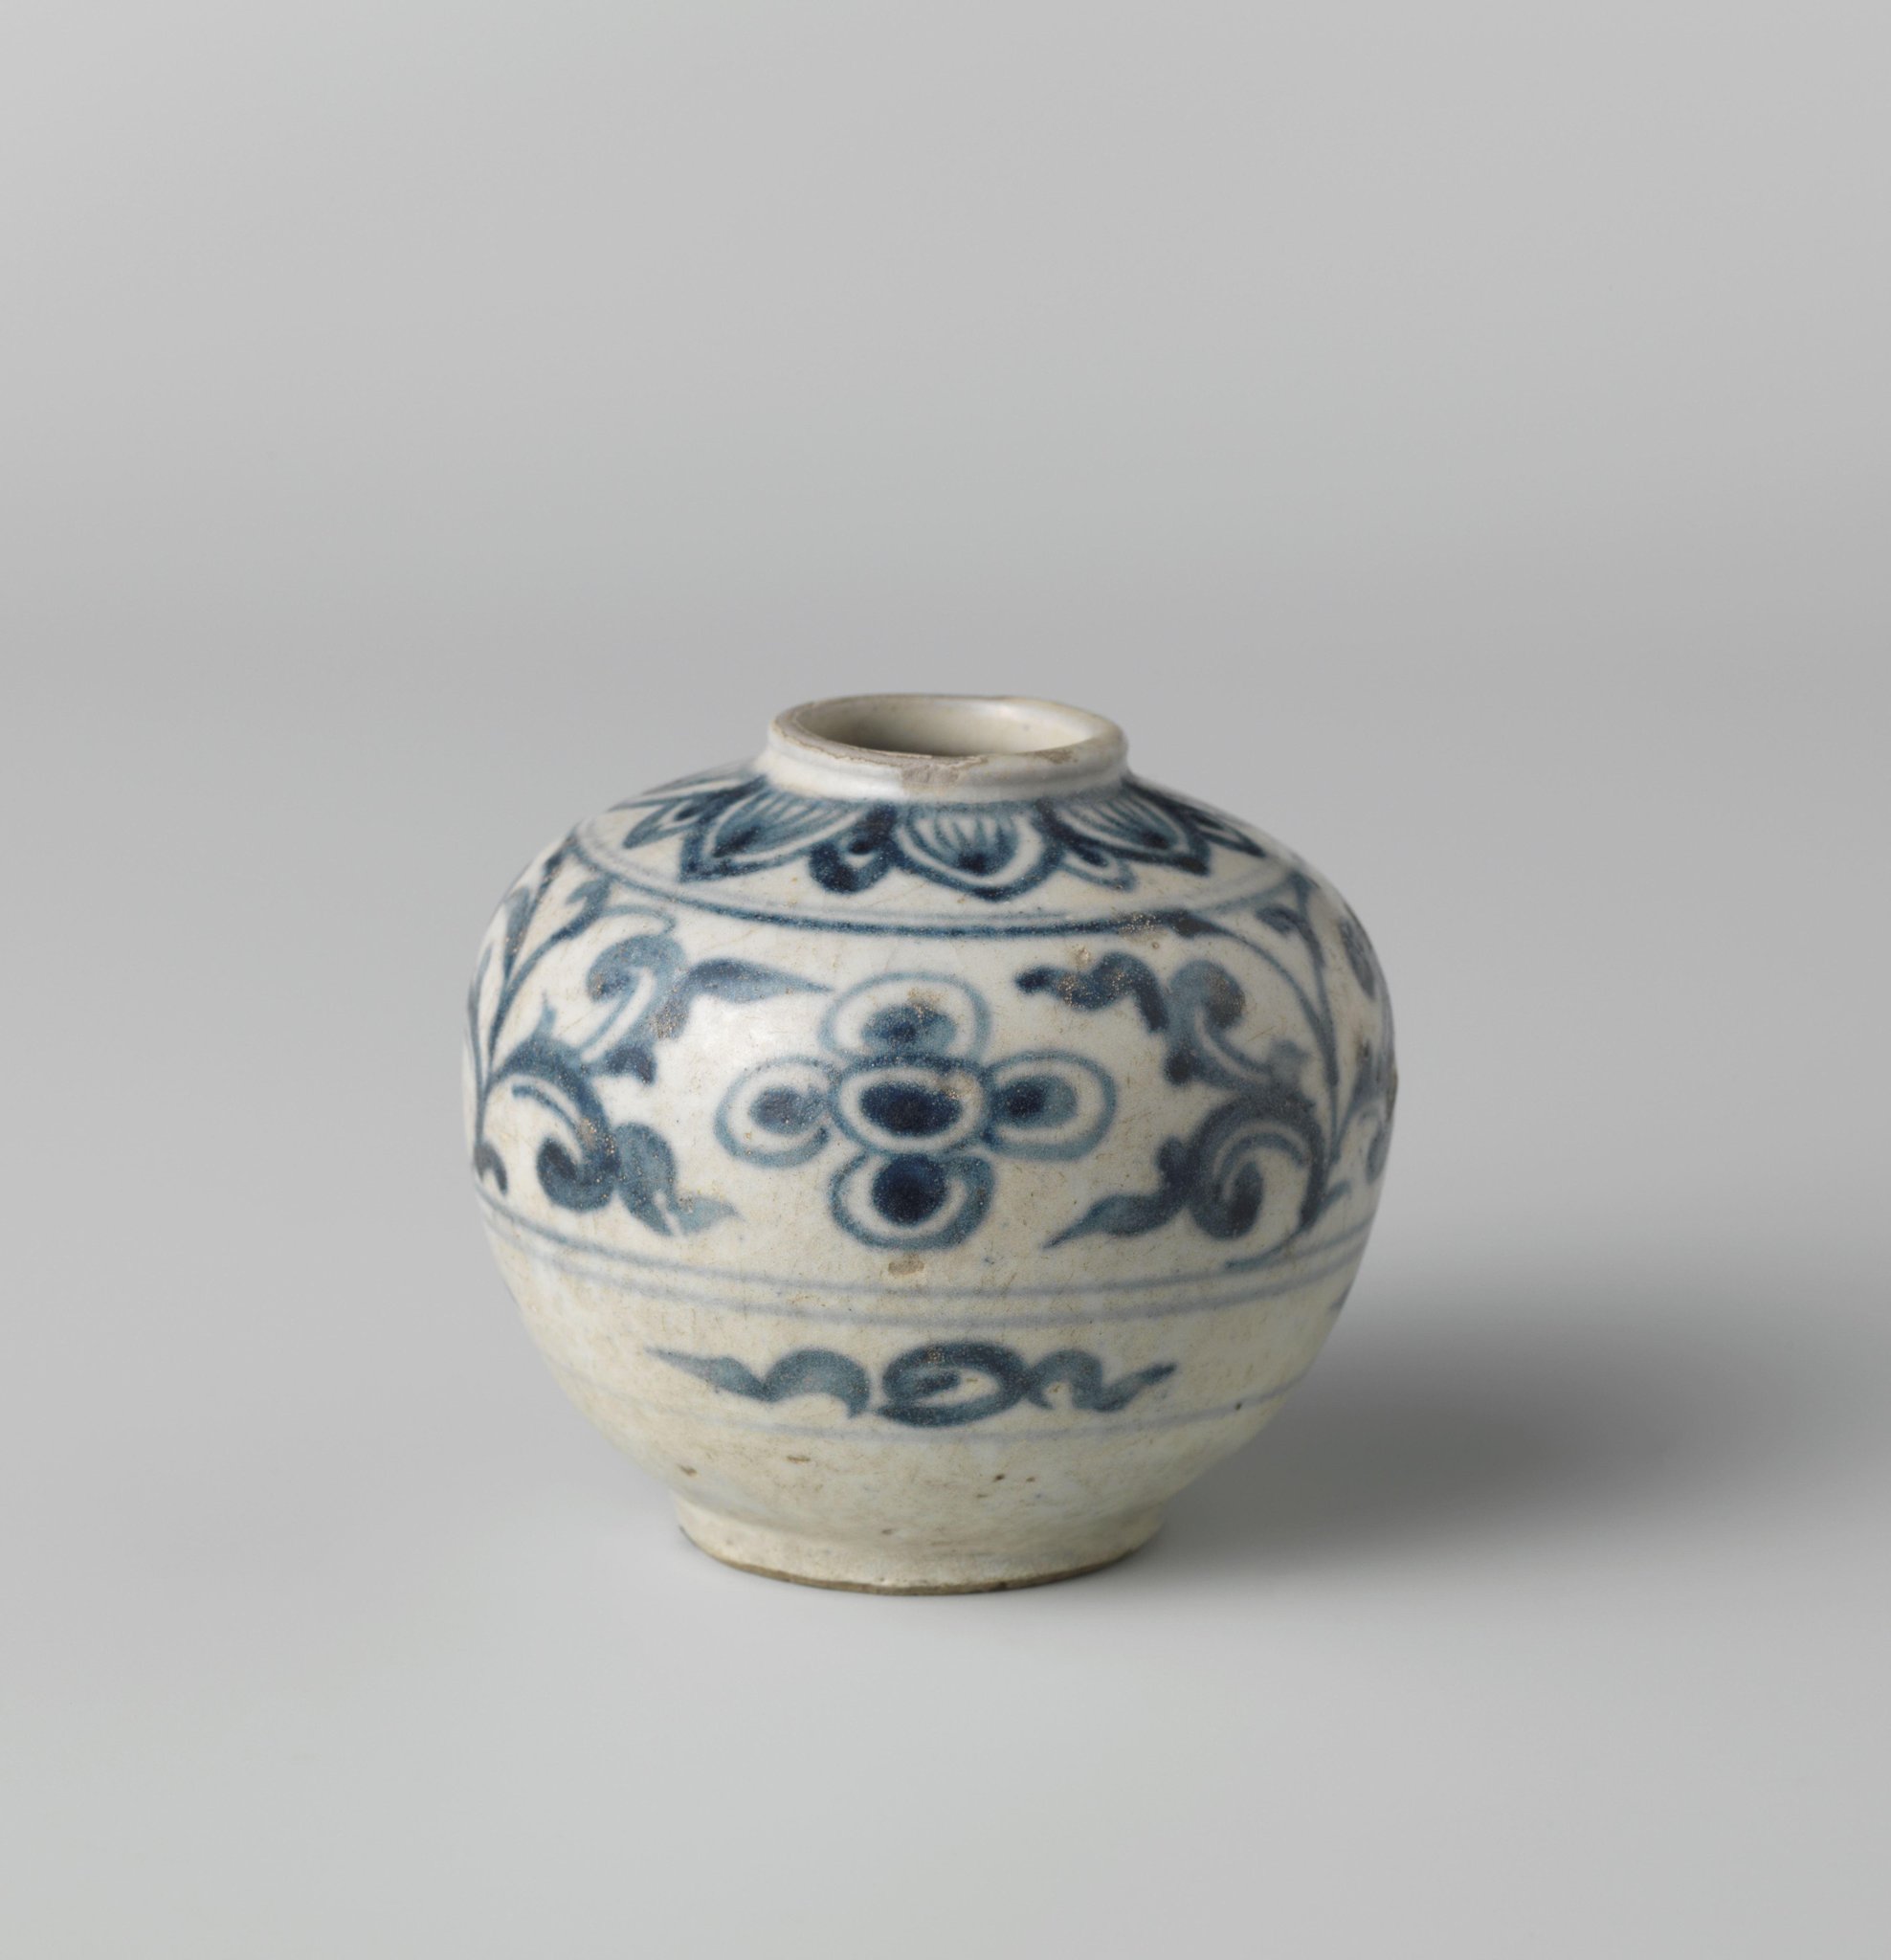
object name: pot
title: Ovoid jar with floral scrolls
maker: Anonymous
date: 1400-1499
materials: cobalt, glaze, paint, porcelain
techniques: firing, turning, vitrification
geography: vietnam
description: Eivormige pot van porselein, beschilderd in onderglazuur blauw. Op de buik een band met bloemranken met daaronder viermaal een rank. Op de schouder een band met bladmotieven. Blauw-wit.